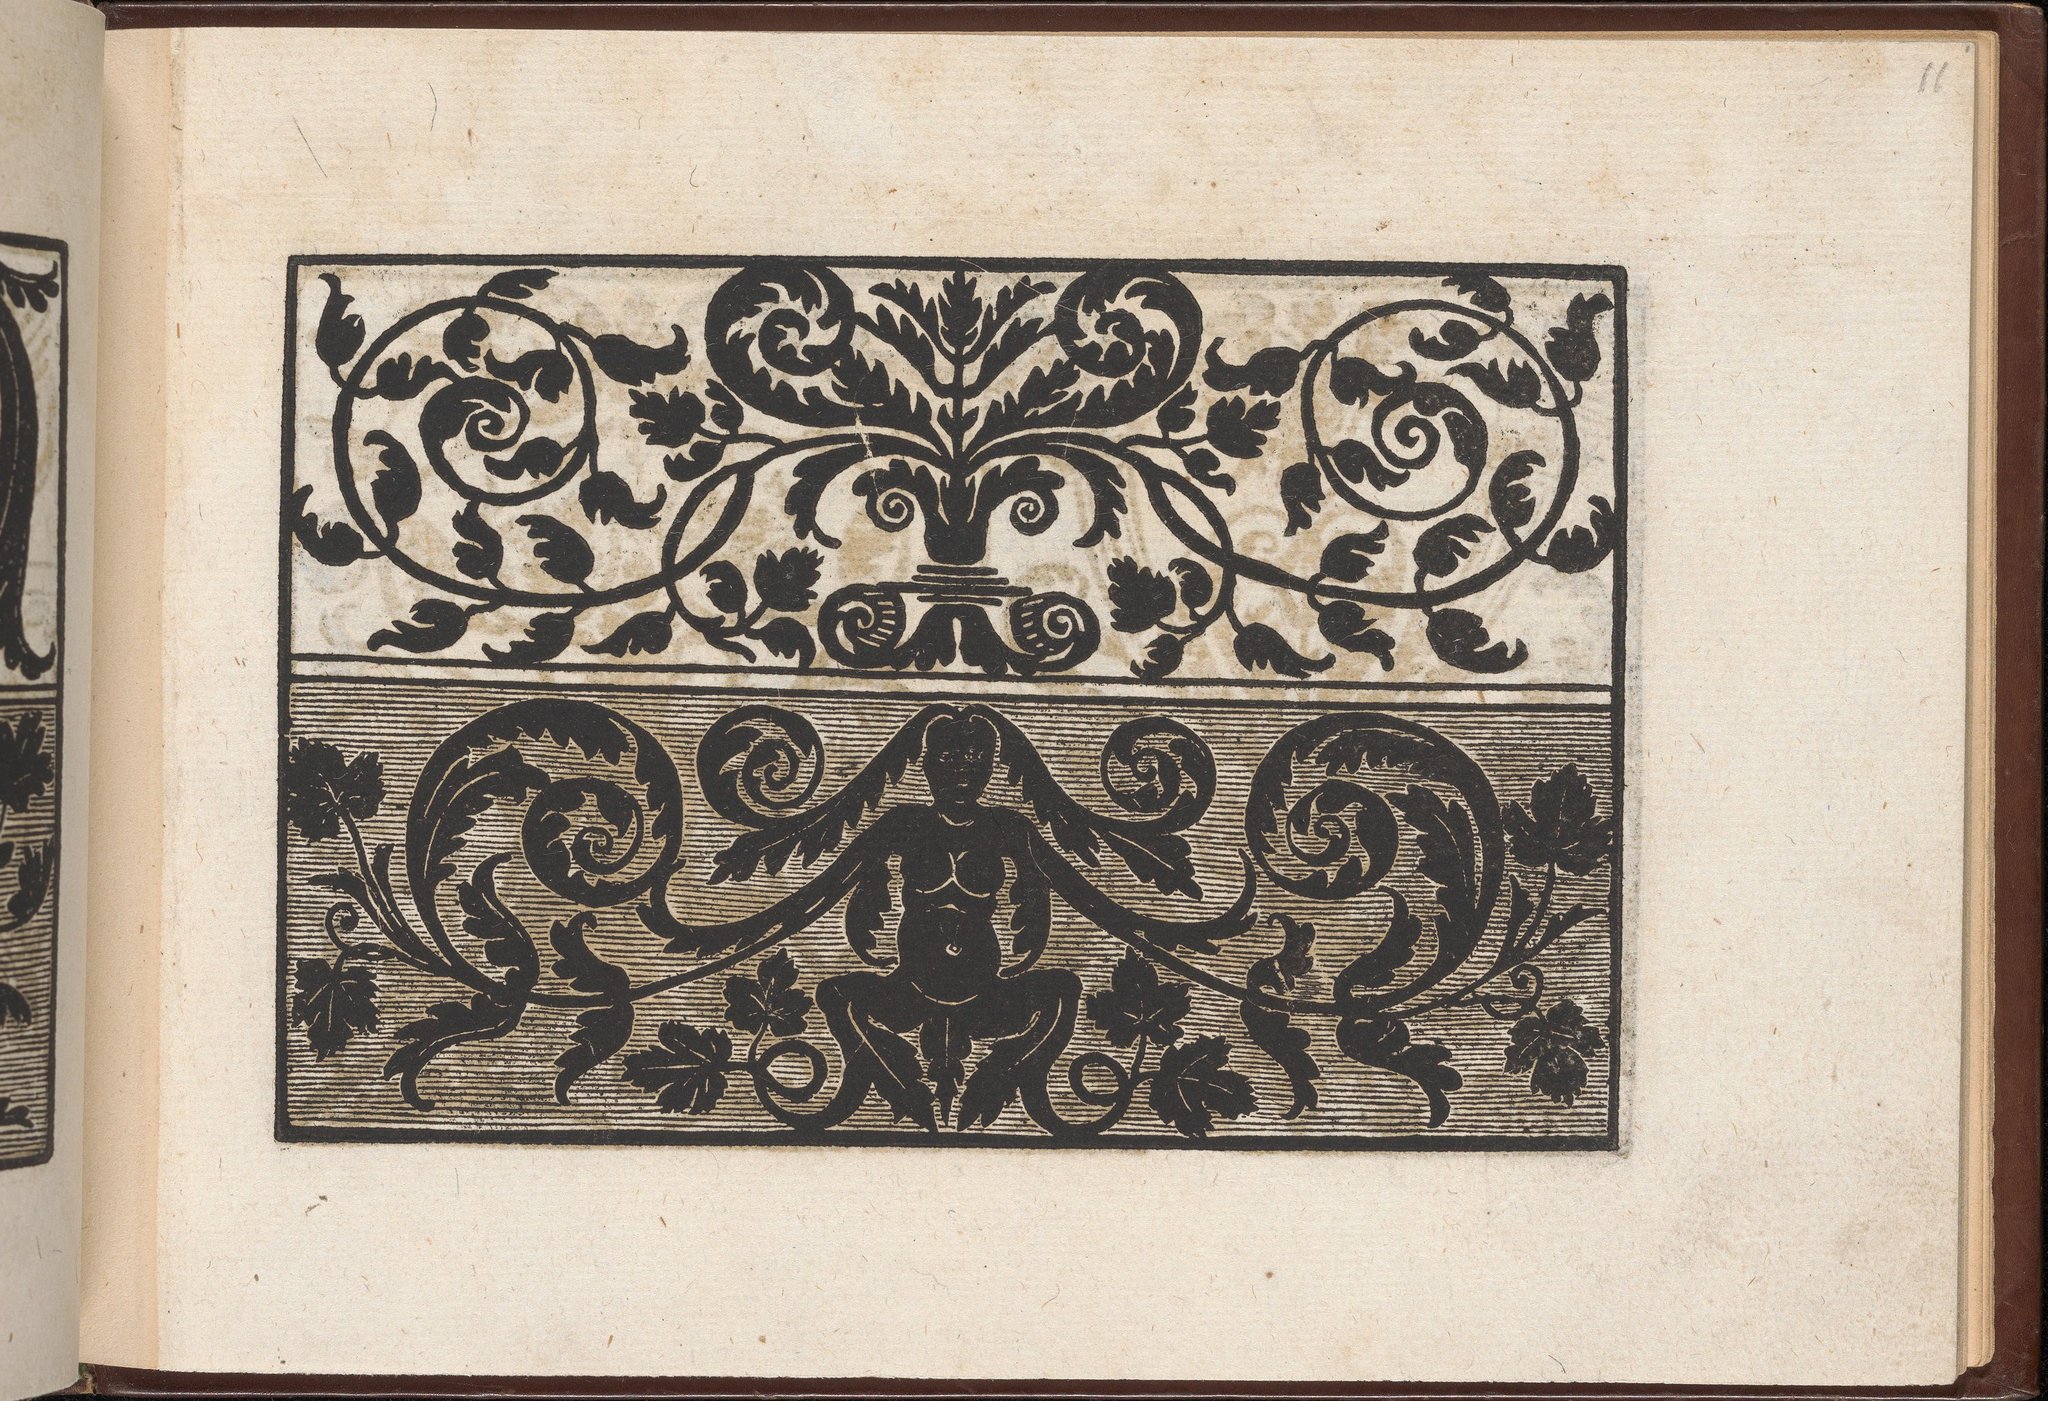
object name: book print ornament architecture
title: Page from Eyn Newe kunstlich moetdelboech alle kunst (Page 11r)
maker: peter quentel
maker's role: publisher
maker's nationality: german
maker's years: 1500-1550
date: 1532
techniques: woodcut